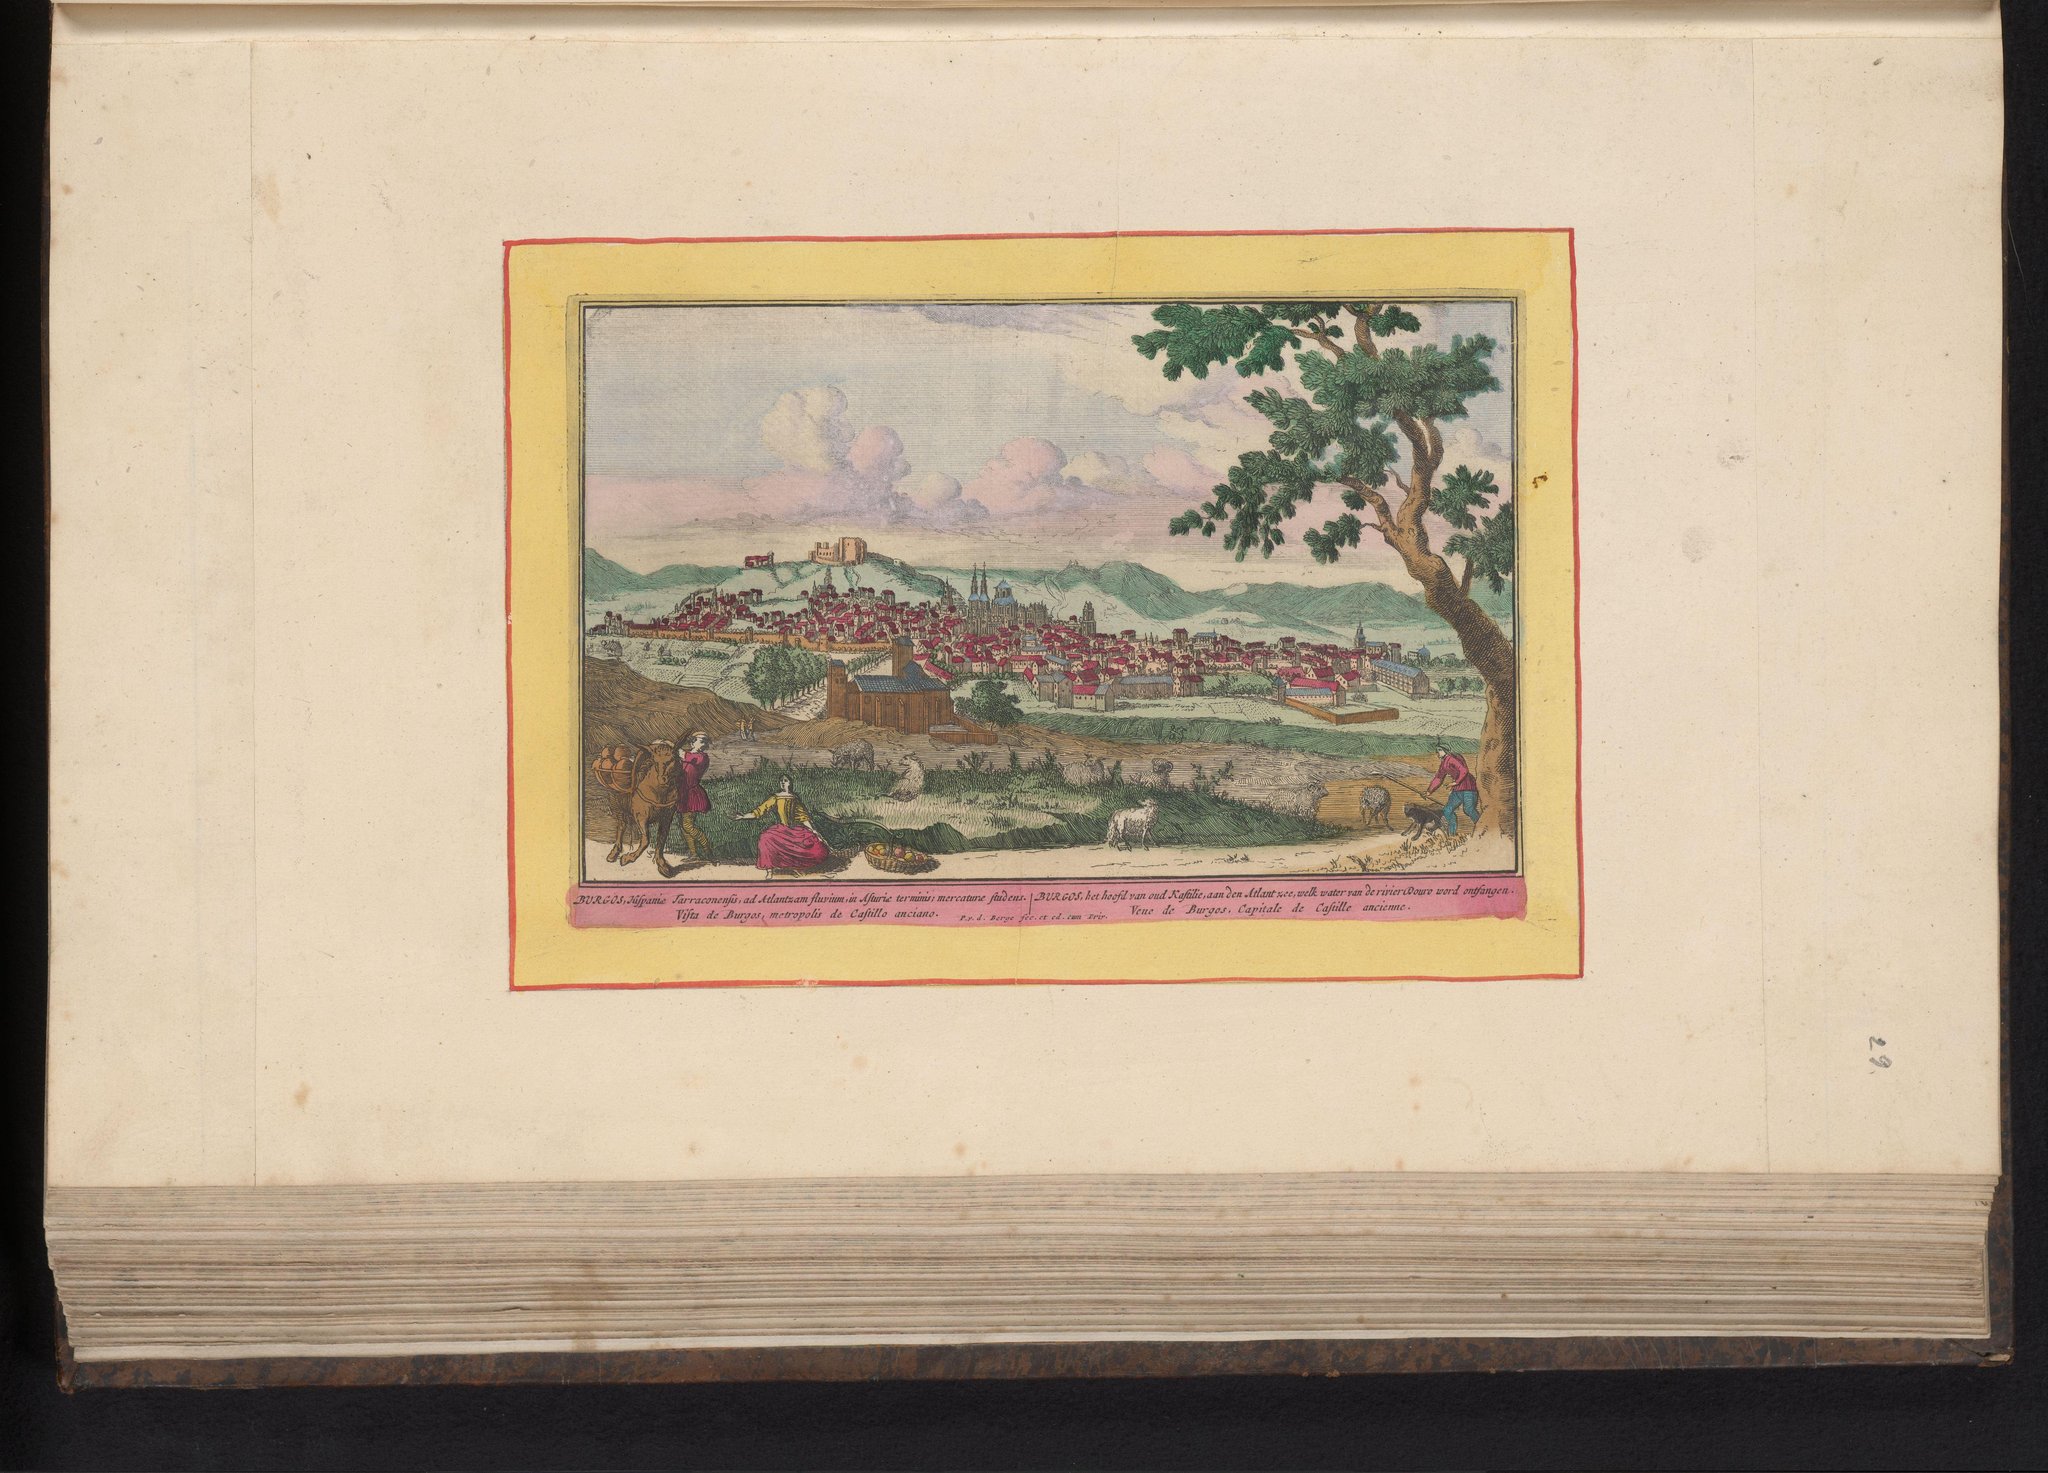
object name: book illustration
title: Burgos, het hoofd van oud Kastilie, aan den Atlant zee, welk water van de rivier Douro word ontfangen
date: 1694-1737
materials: paper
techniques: etching, hand coloring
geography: the hague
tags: prospect of city, town panorama, silhouette of city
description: Prent uit: Theatrum Hispaniæ, exhibens regni urbes, villas ac viridaria magis illustria. Het aanmerkelykste en voortreffelykste in Spanjen (...). Amsterdam: Pieter van den Berge, ca. 1694-1737.